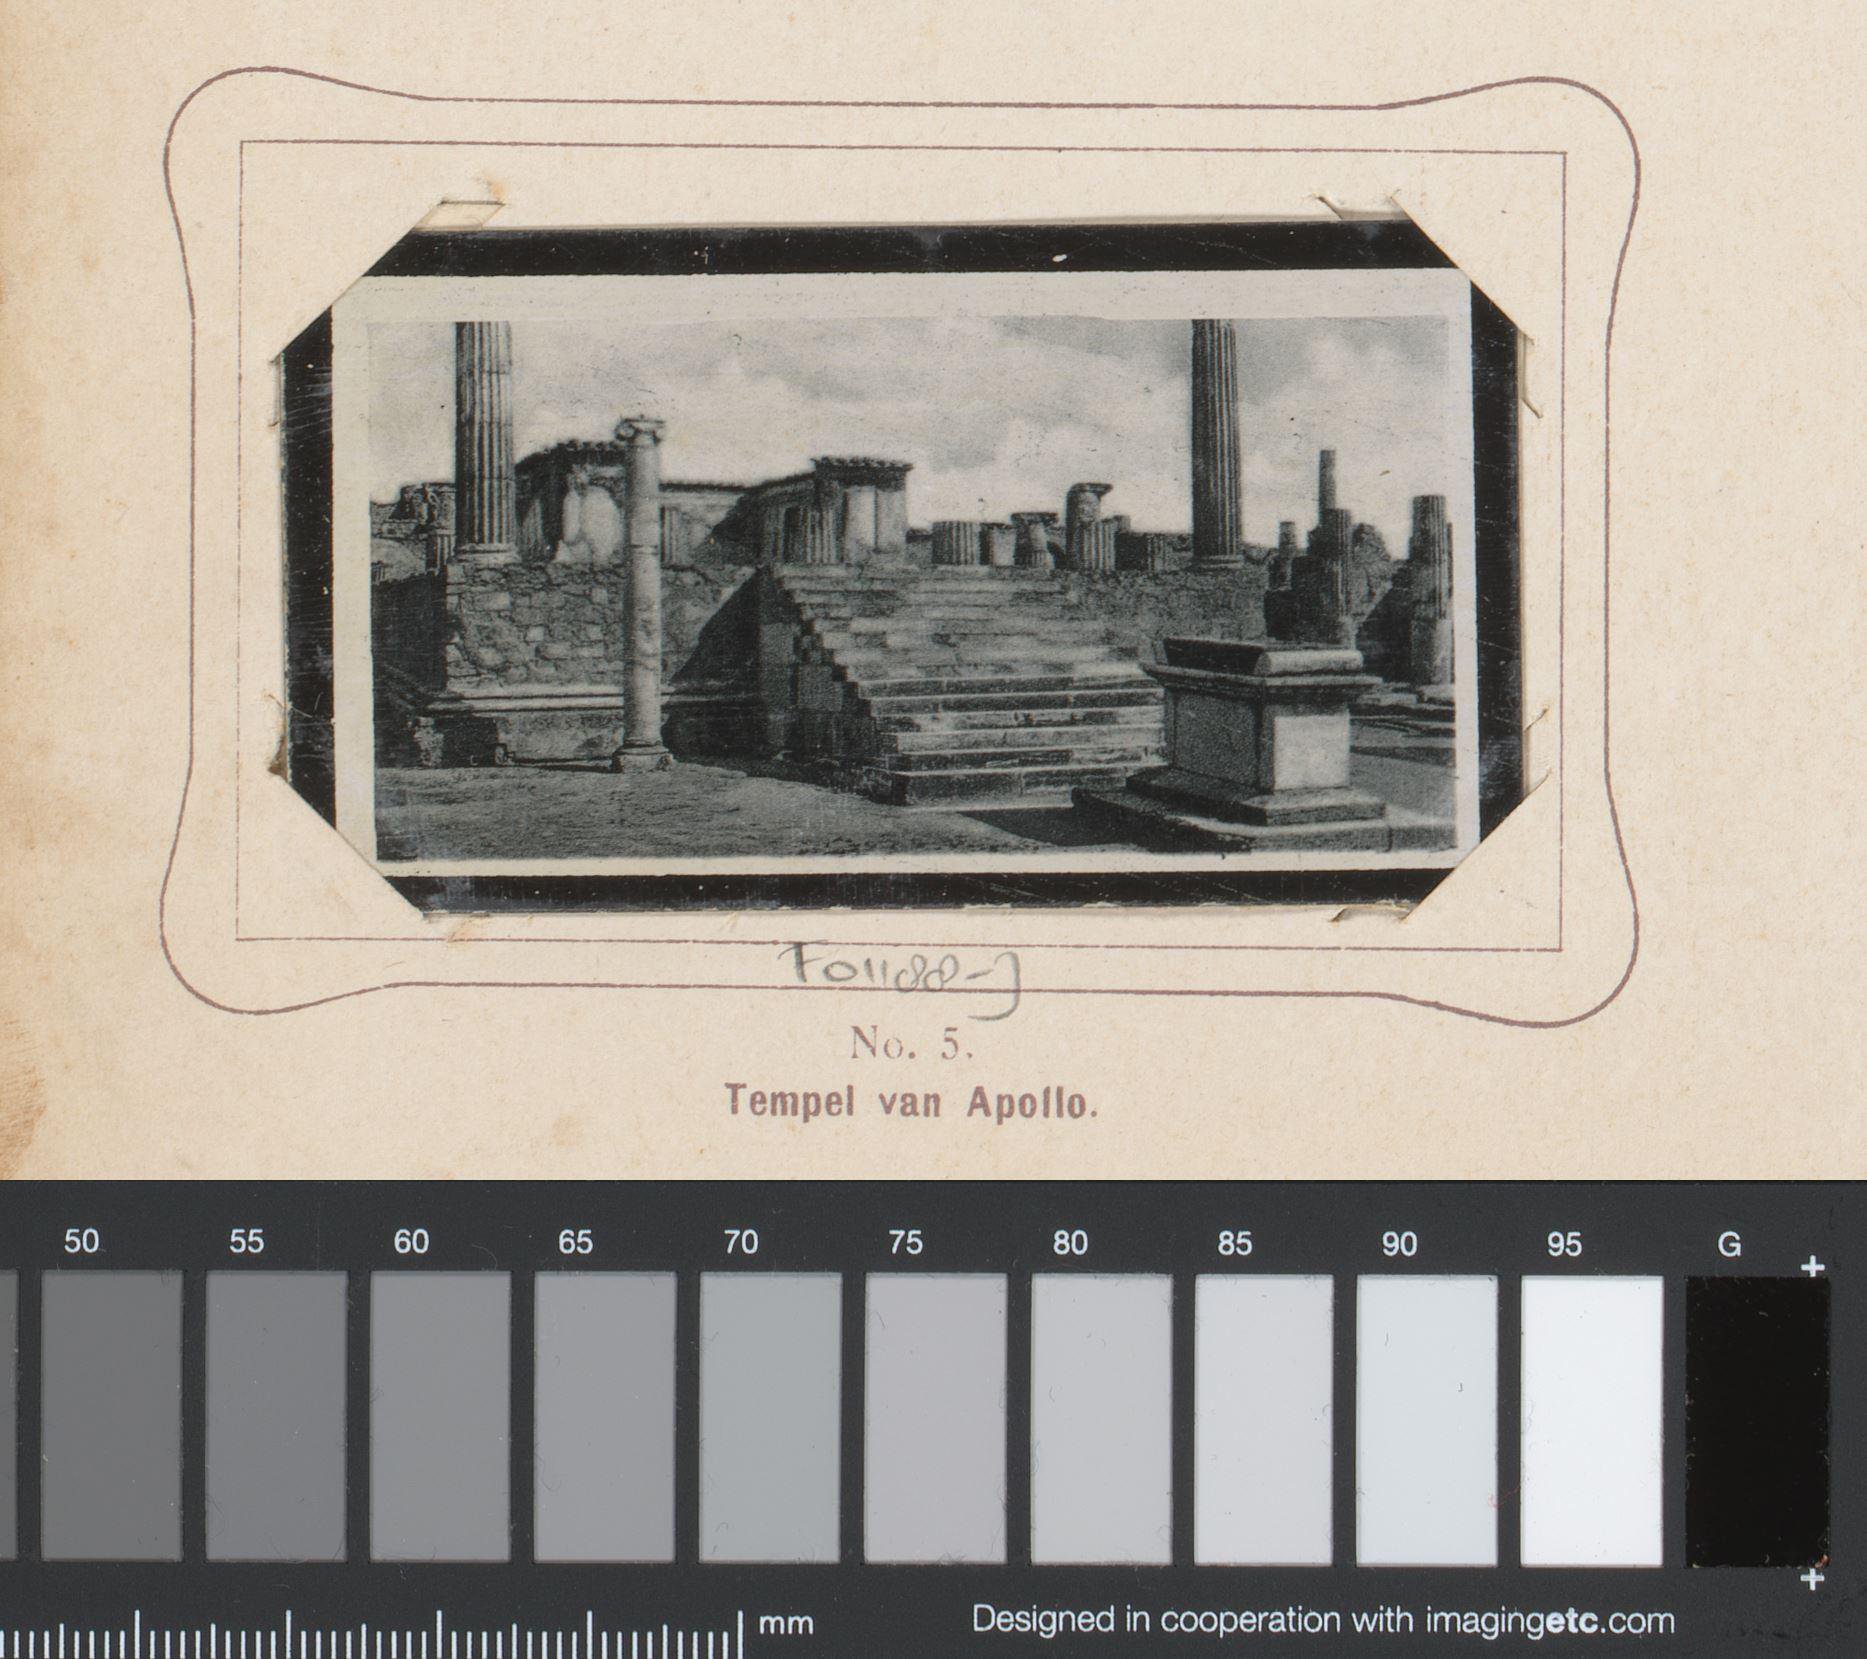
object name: photomechanical print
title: Ruïnes van de Tempel van Apollo in Pompeï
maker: Anonymous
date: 1906-1907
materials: paper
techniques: photograph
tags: landscape with ruins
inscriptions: inscription: ‘No. 5./ Tempel van Apollo.’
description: Deze prent maakt deel uit van een album.